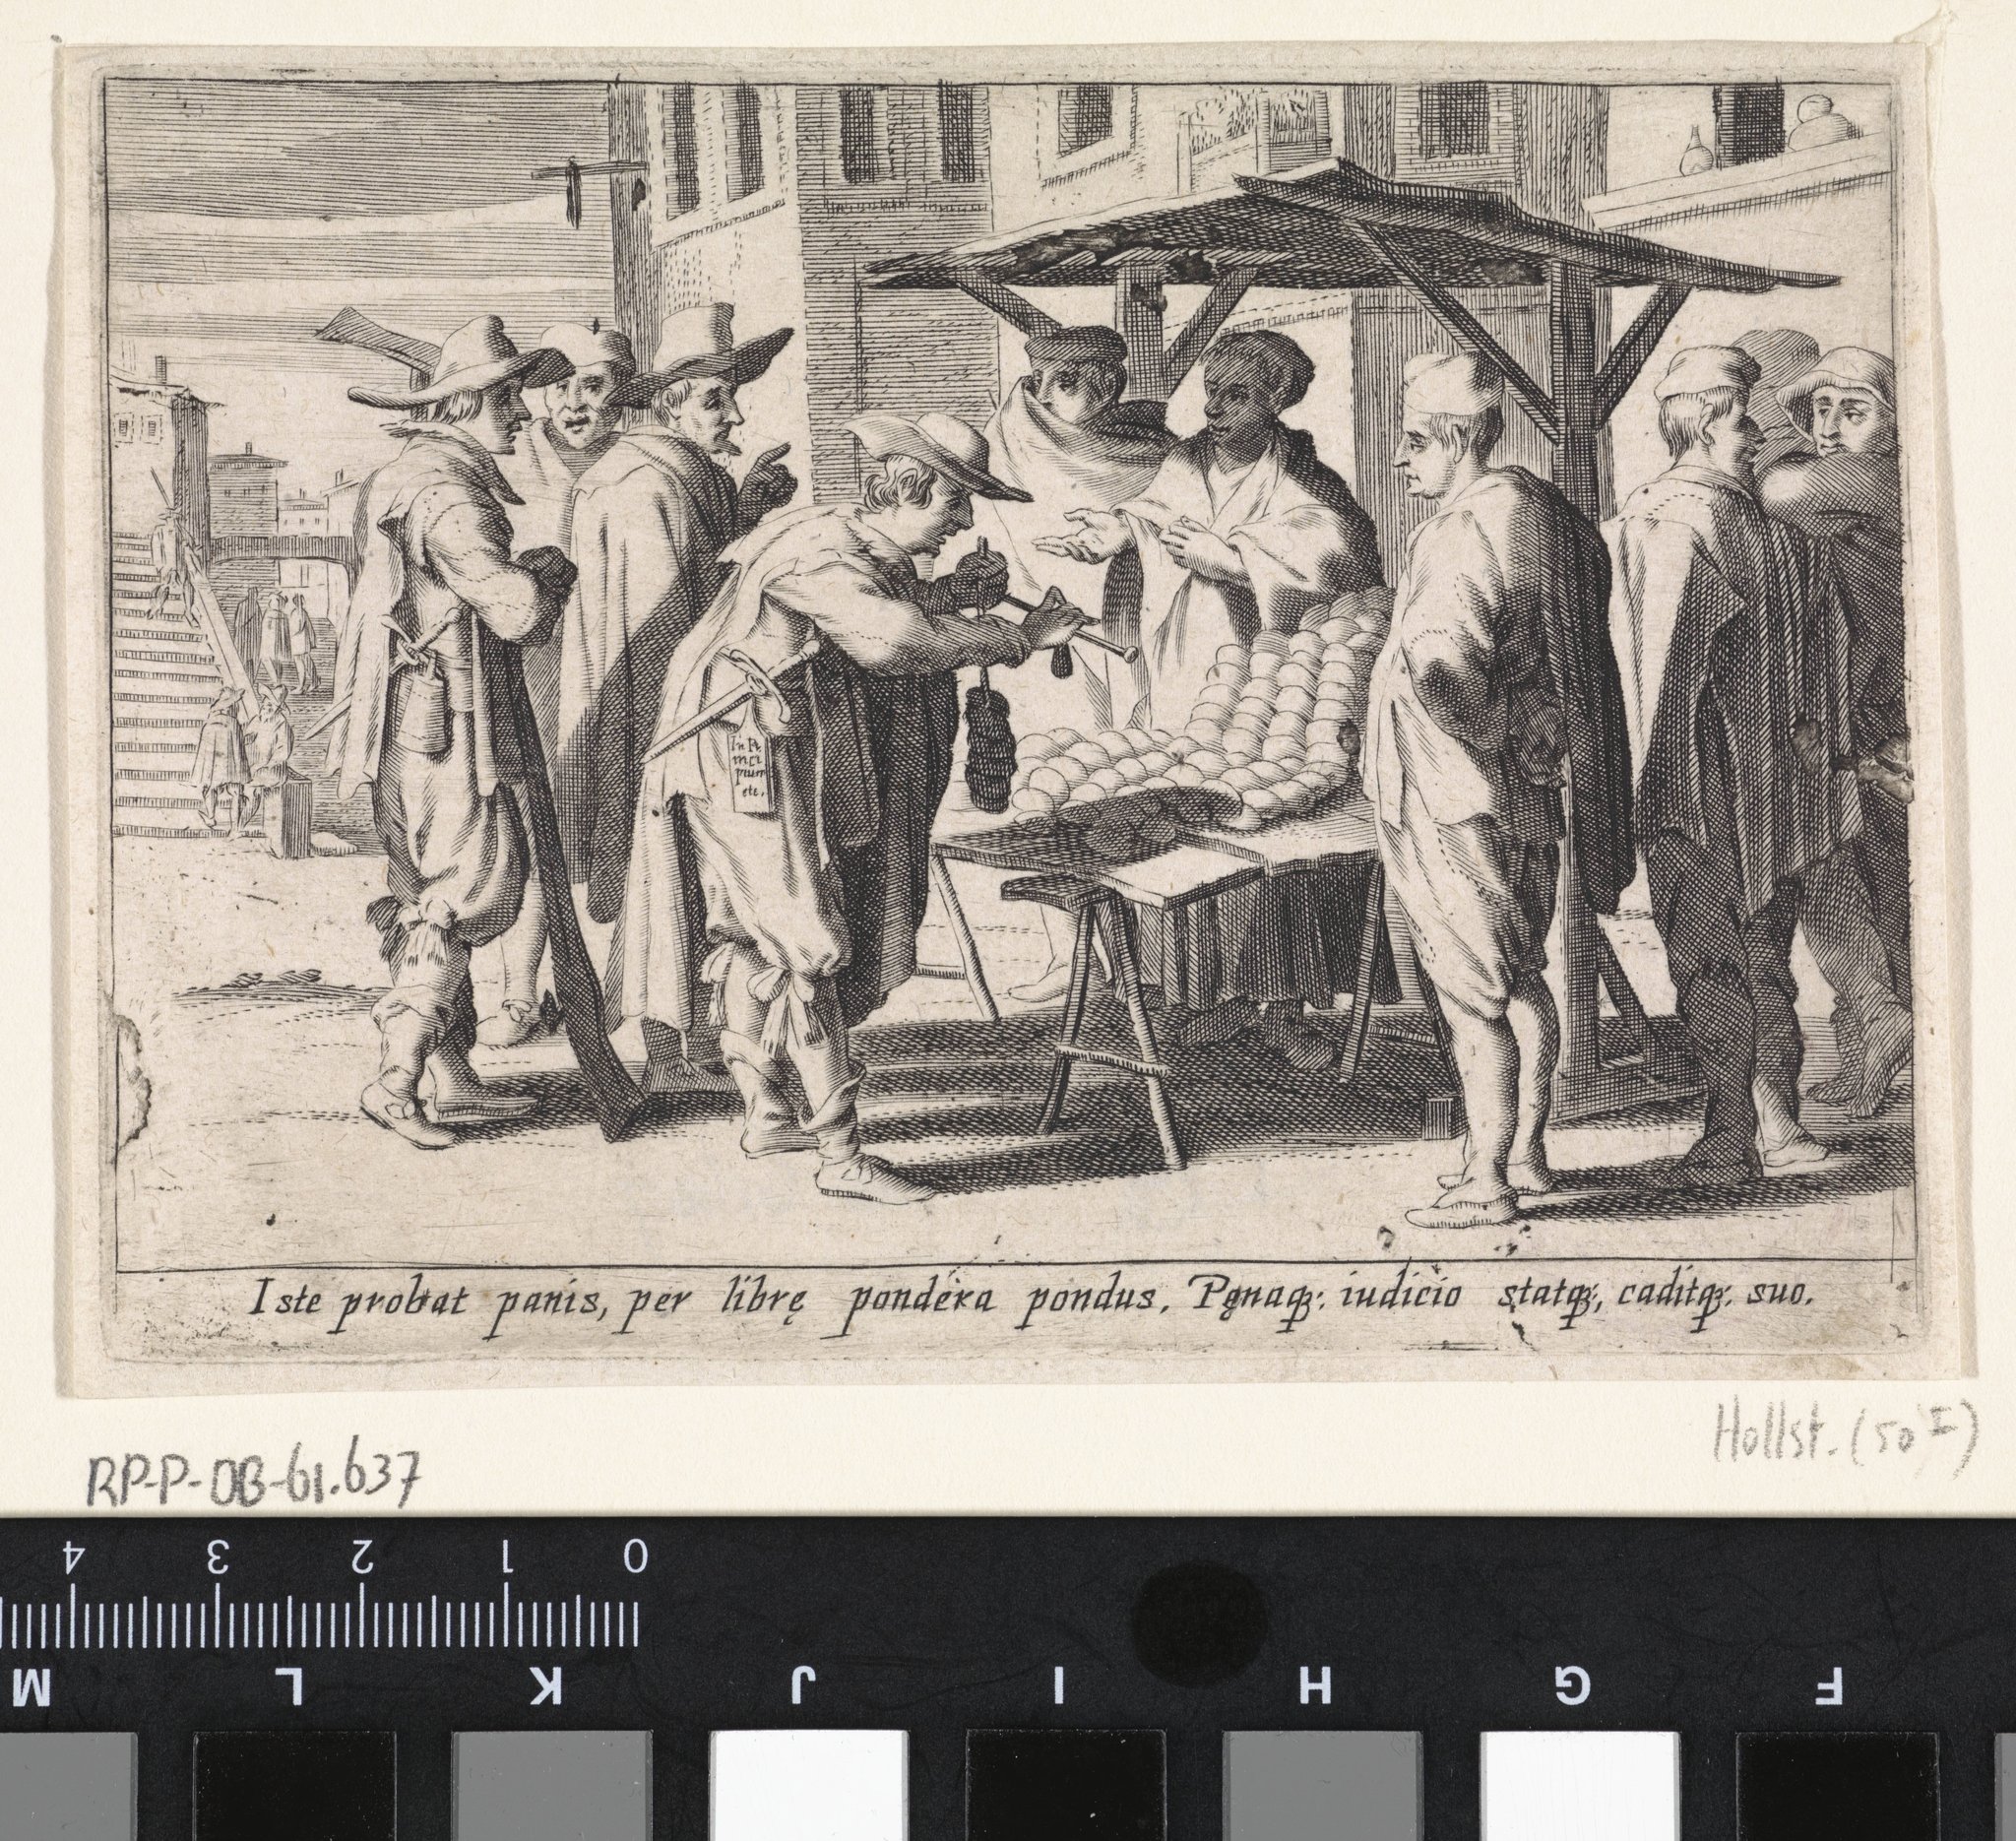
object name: print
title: Verkoopster bij kraam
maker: Anonymous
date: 1613-1667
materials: paper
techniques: engraving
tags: merchant, salesman - bb - women engaged in trade and commerce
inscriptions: collector's mark: Lugt 240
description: Een vrouw verkoopt haar waar. Diverse mannen hebben zich rond haar kraam verzameld. Eén van hen bekijkt het aanbod. In de marge een onderschrift in het Latijn.